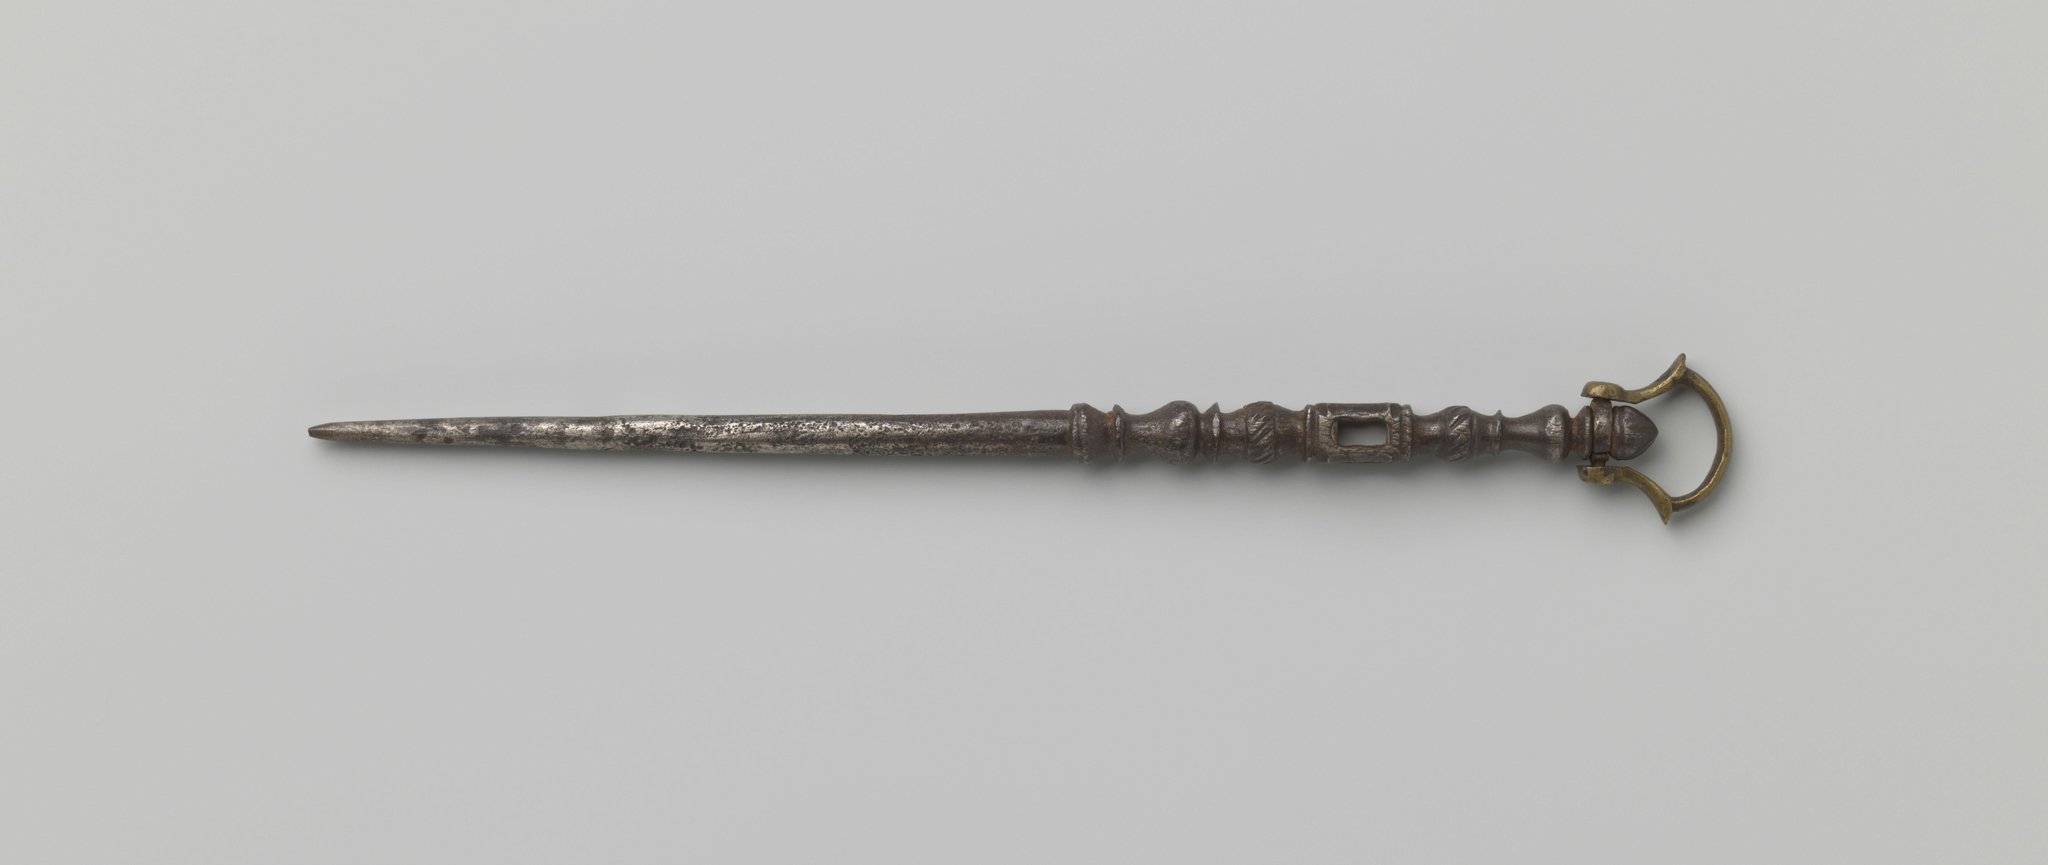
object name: knitting needle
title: Hulpbreipen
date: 1600-1699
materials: copper, iron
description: Een hulpbreipen, waarvan het handvat in verschillende geledingen geprofileerd is en in het midden een open vierkanten lantaarn vertoont. Boven aan de pen bevindt zich een beugel. Pen van ijzer beugel van koper.